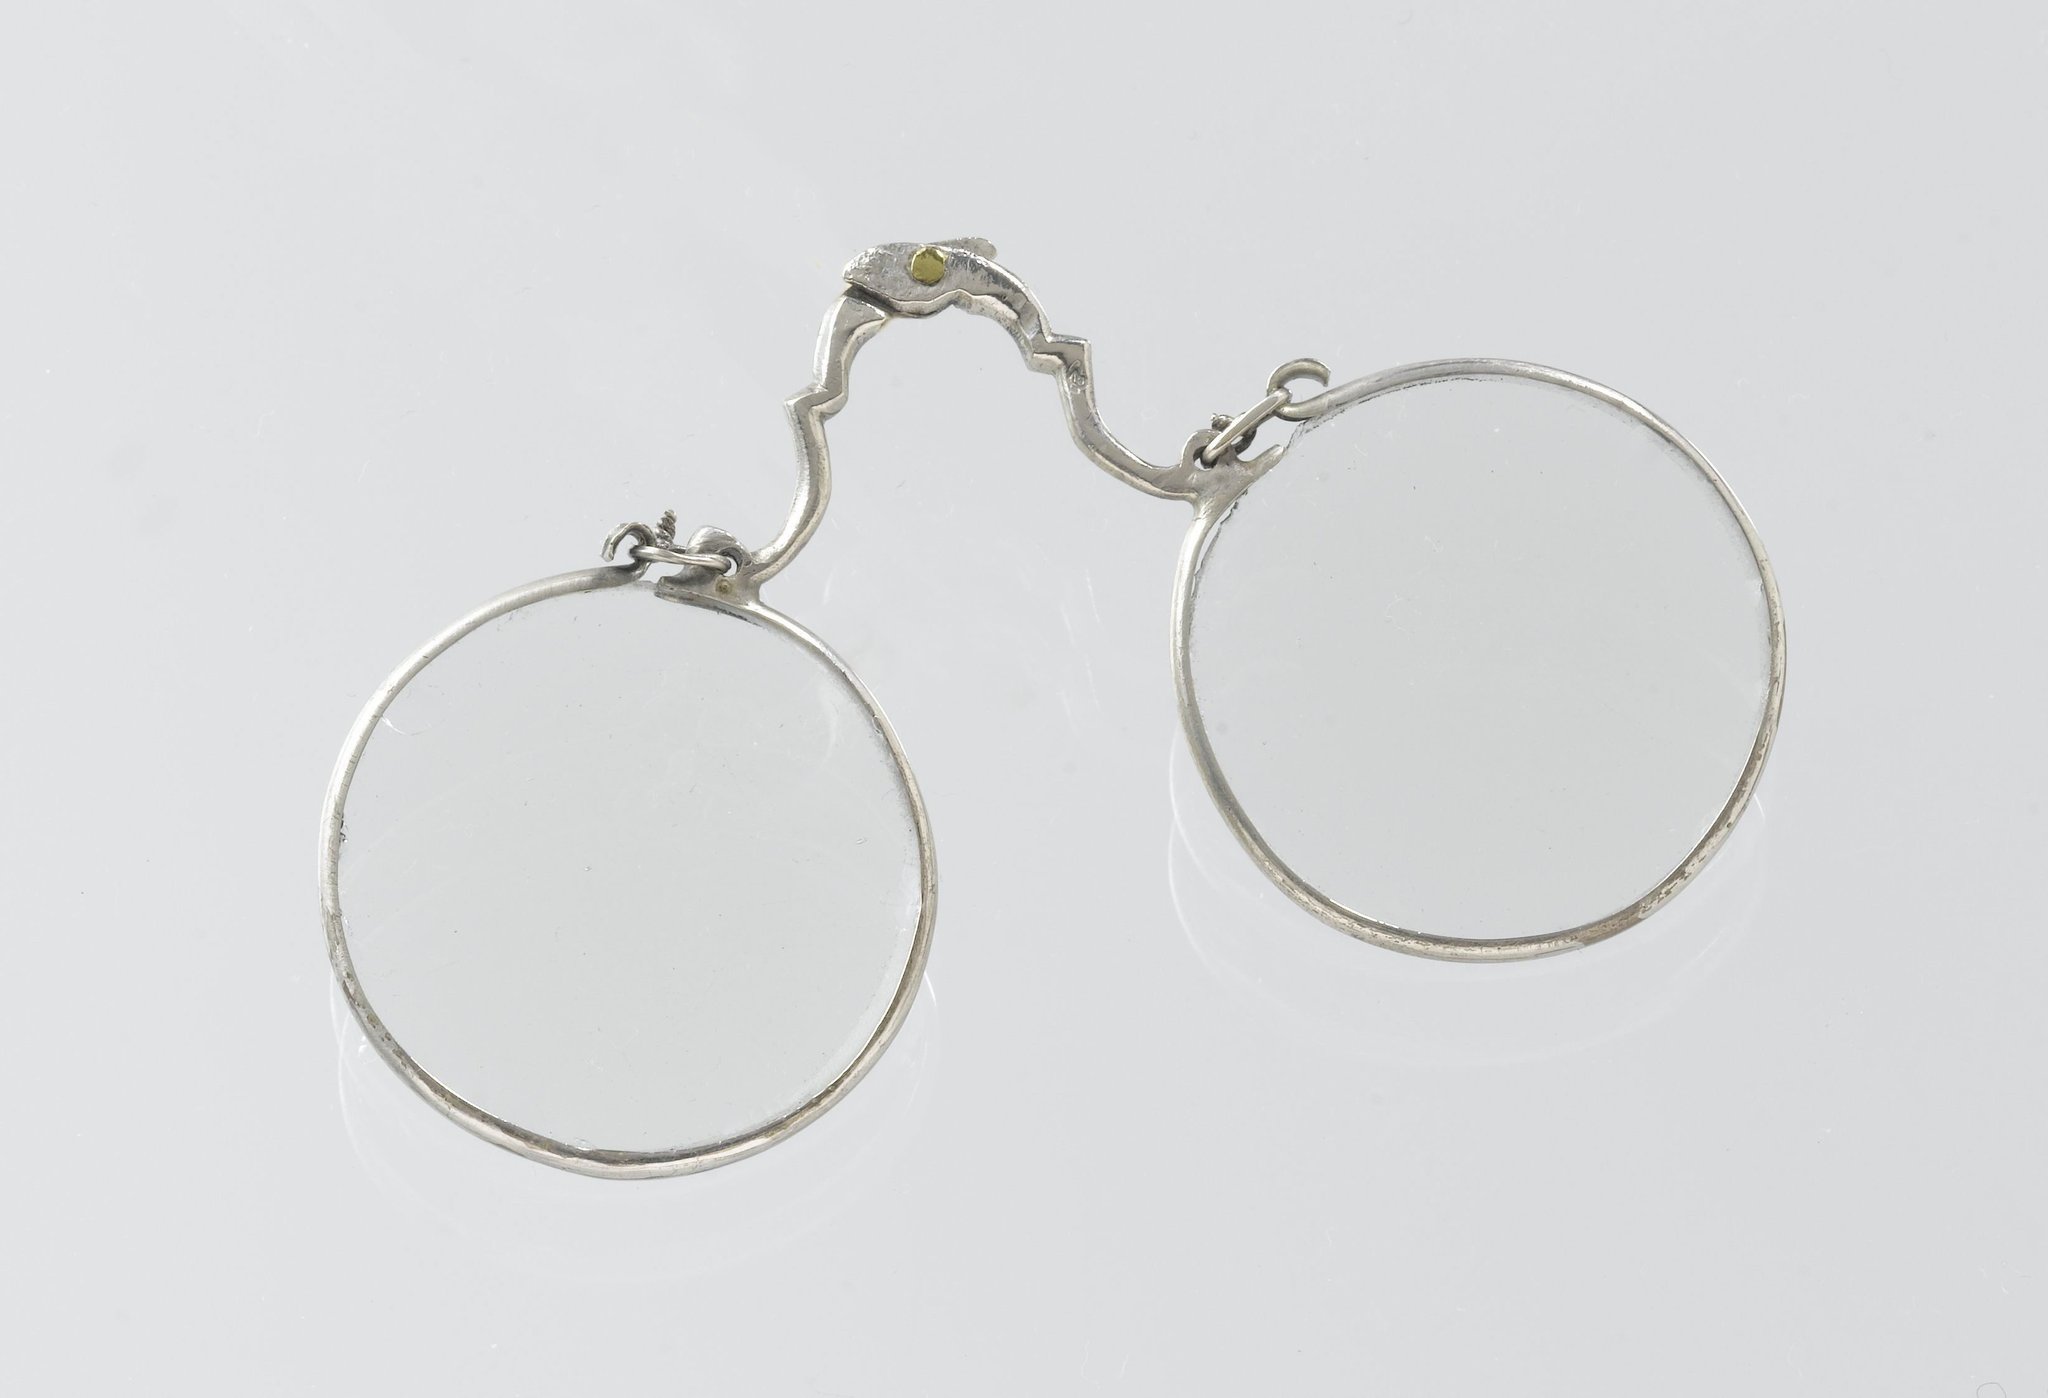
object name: scharnierbril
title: Scharnierbril van Willem Credo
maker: Anonymous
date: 1733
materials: glass, silver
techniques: manufacturing, forging, grinding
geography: netherlands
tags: willem credo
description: Scharnierbril met montuur van zilver en ronde geslepen glazen.